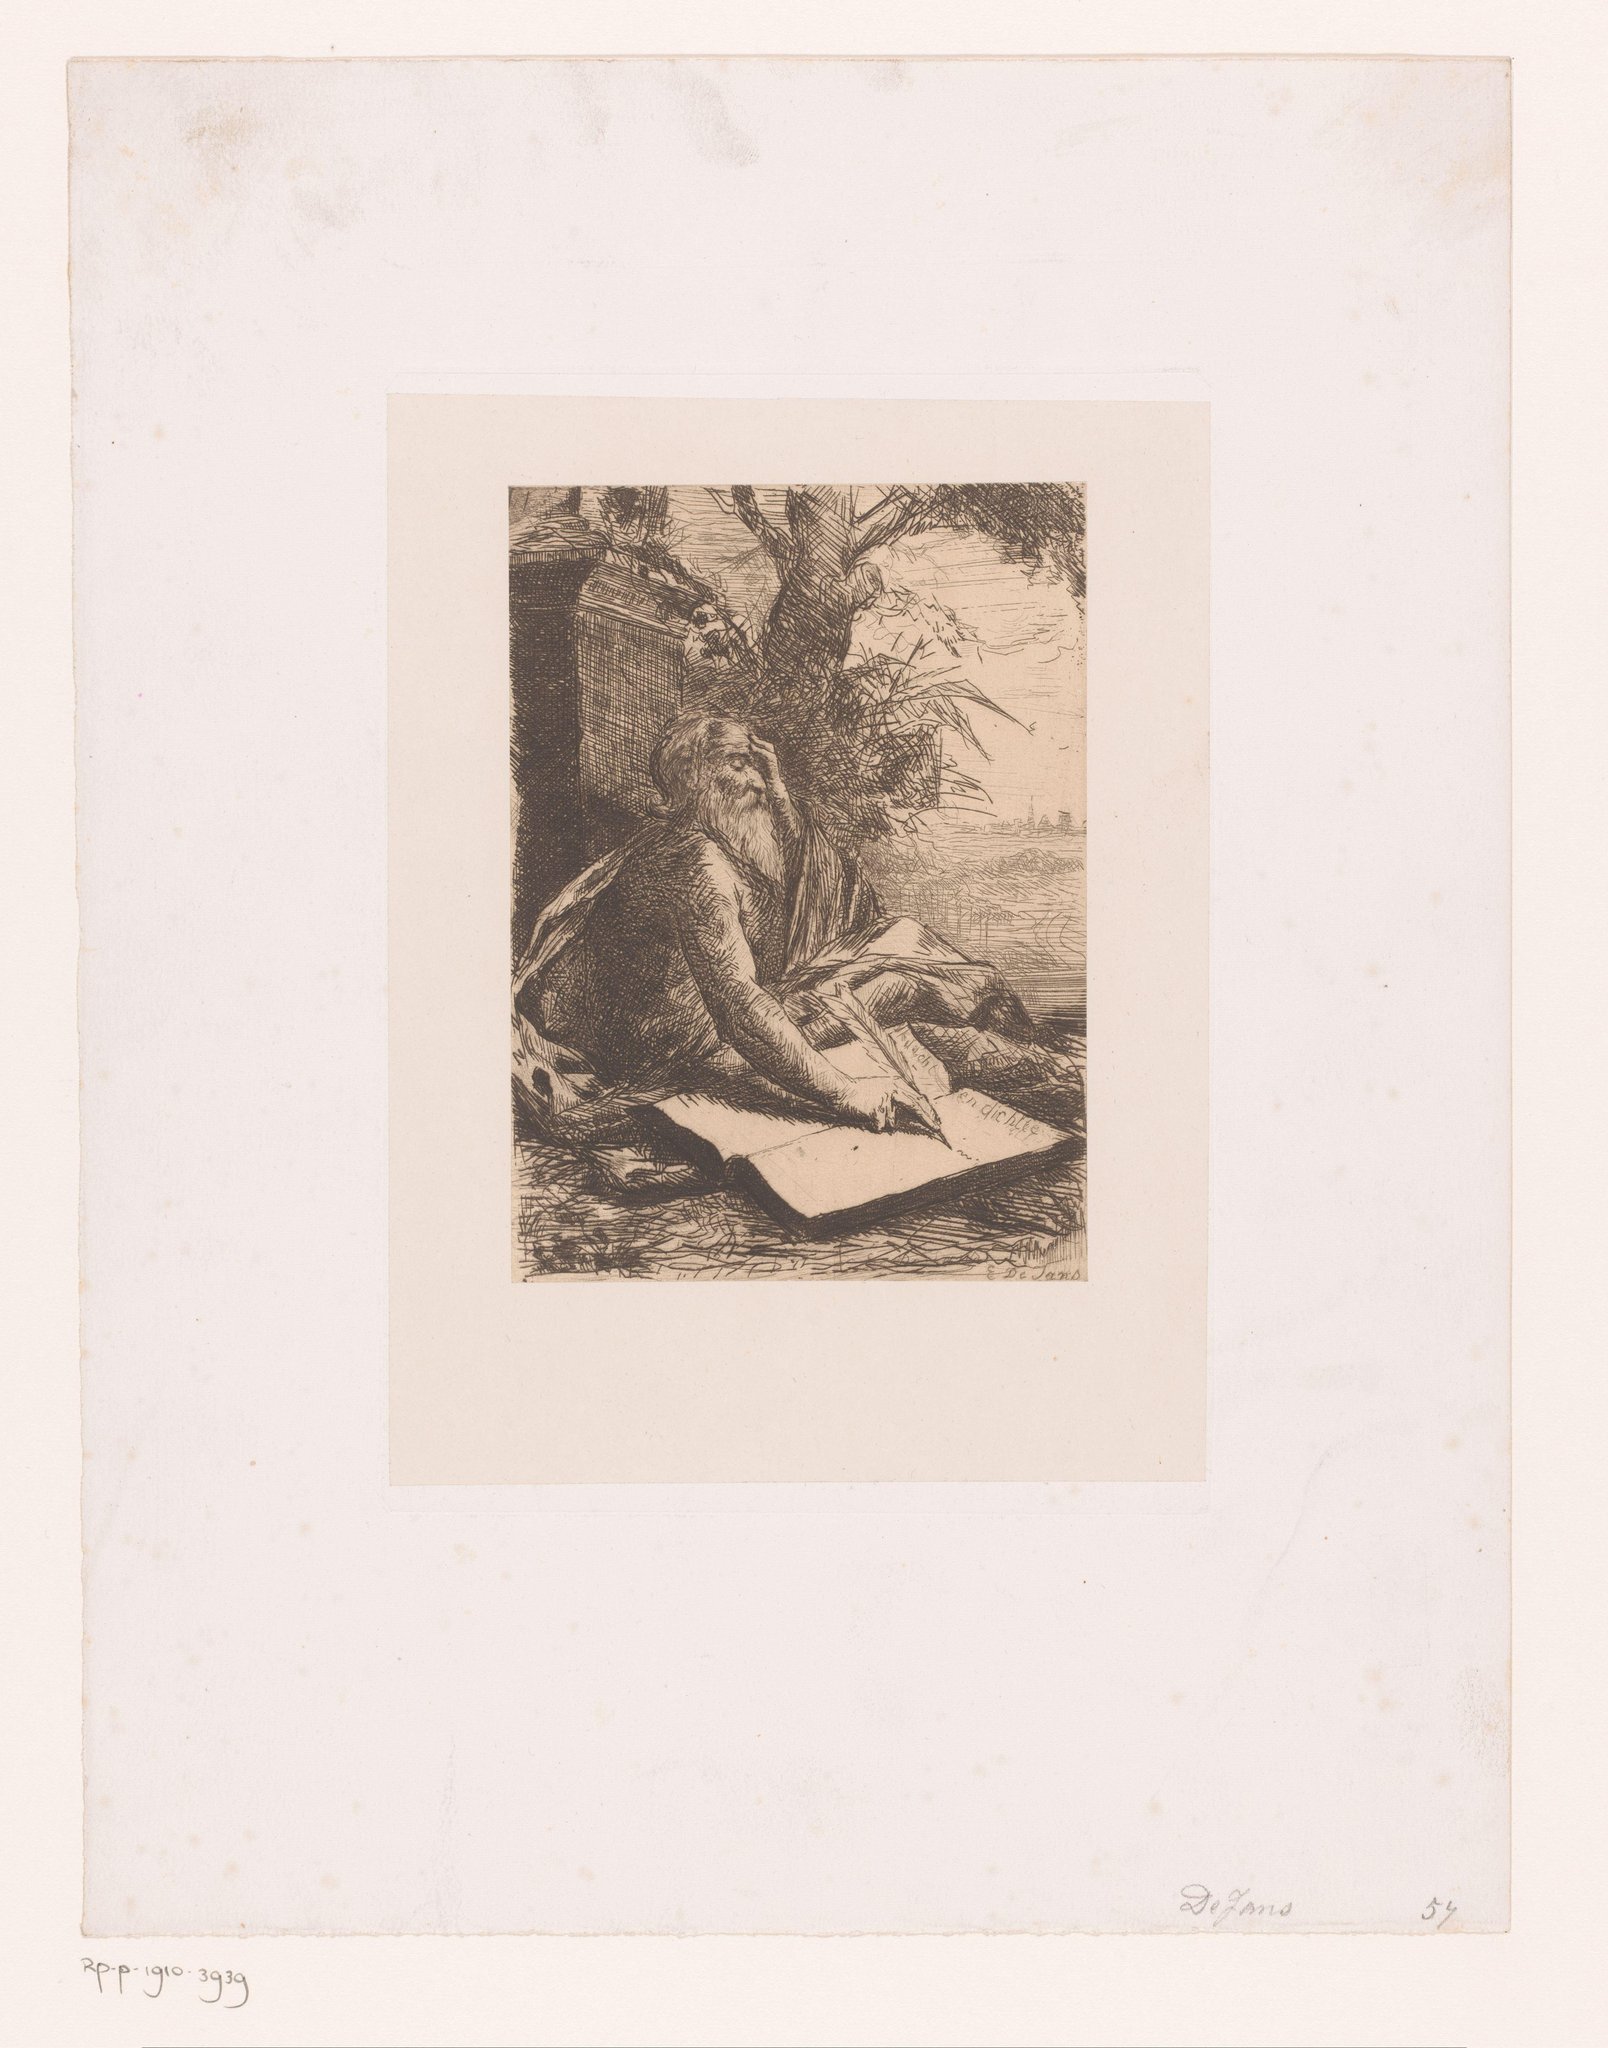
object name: print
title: Dichter schrijvend in een landschap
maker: edouard de jans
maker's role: print maker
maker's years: 1855-1919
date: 1865-1910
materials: paper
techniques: drypoint, etching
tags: author, poet writing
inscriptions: collector's mark: Lugt 2228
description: De regel "ik dacht en dichtte" leesbaar in het boek op de grond.